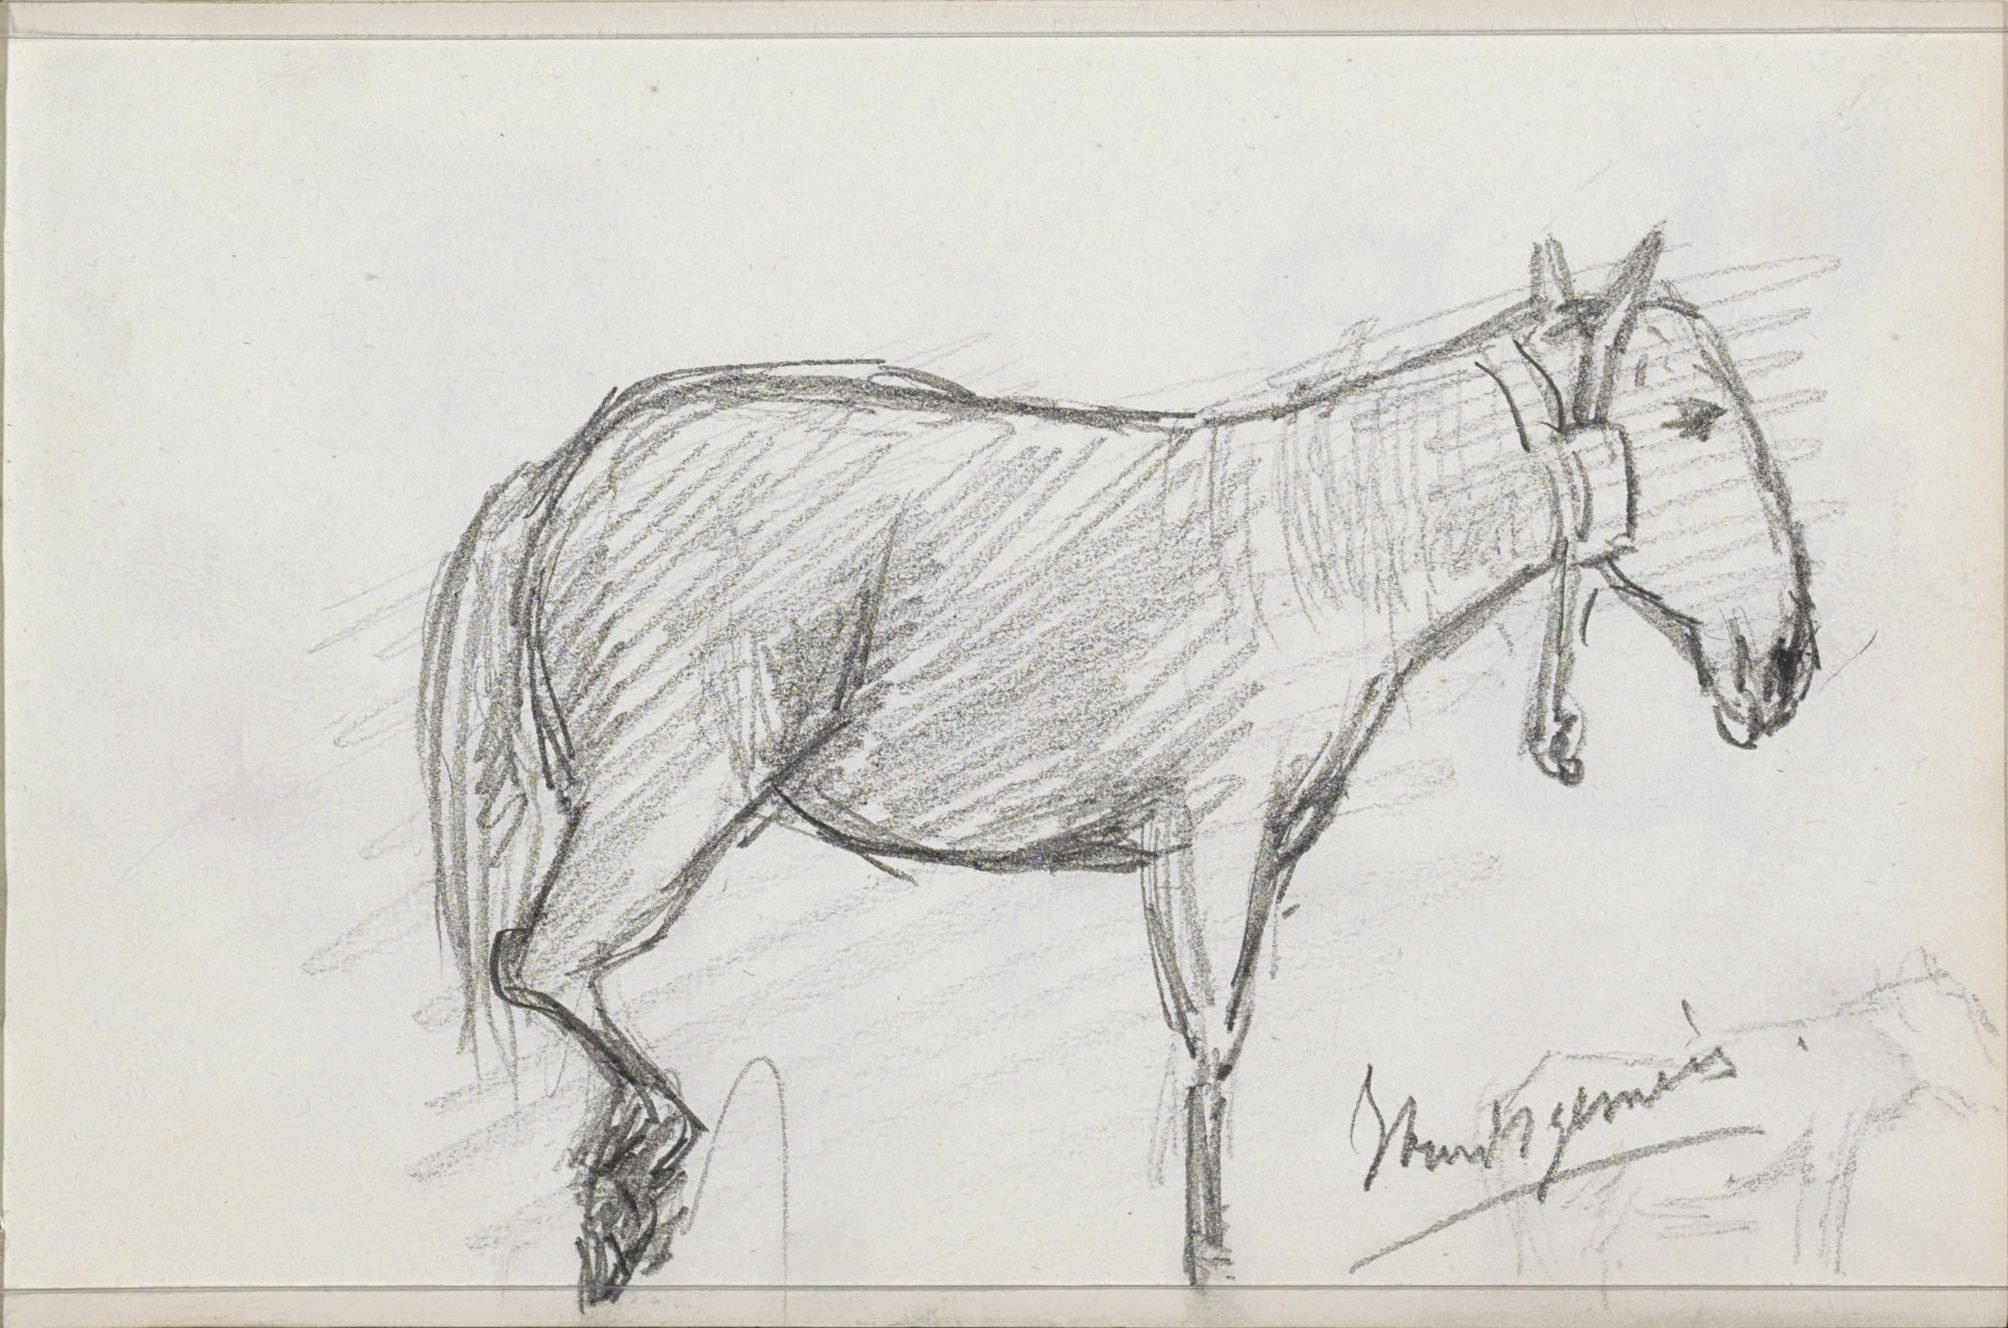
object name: sketchbook leaf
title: Paard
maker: isaac gosschalk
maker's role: draughtsman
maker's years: 1838-1907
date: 1860-1861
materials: paper, pencil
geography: switzerland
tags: horse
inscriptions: annotation: ‘[...]tun[...]geme[...]’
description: Blad 11 recto uit een schetsboek met 29 bladen.